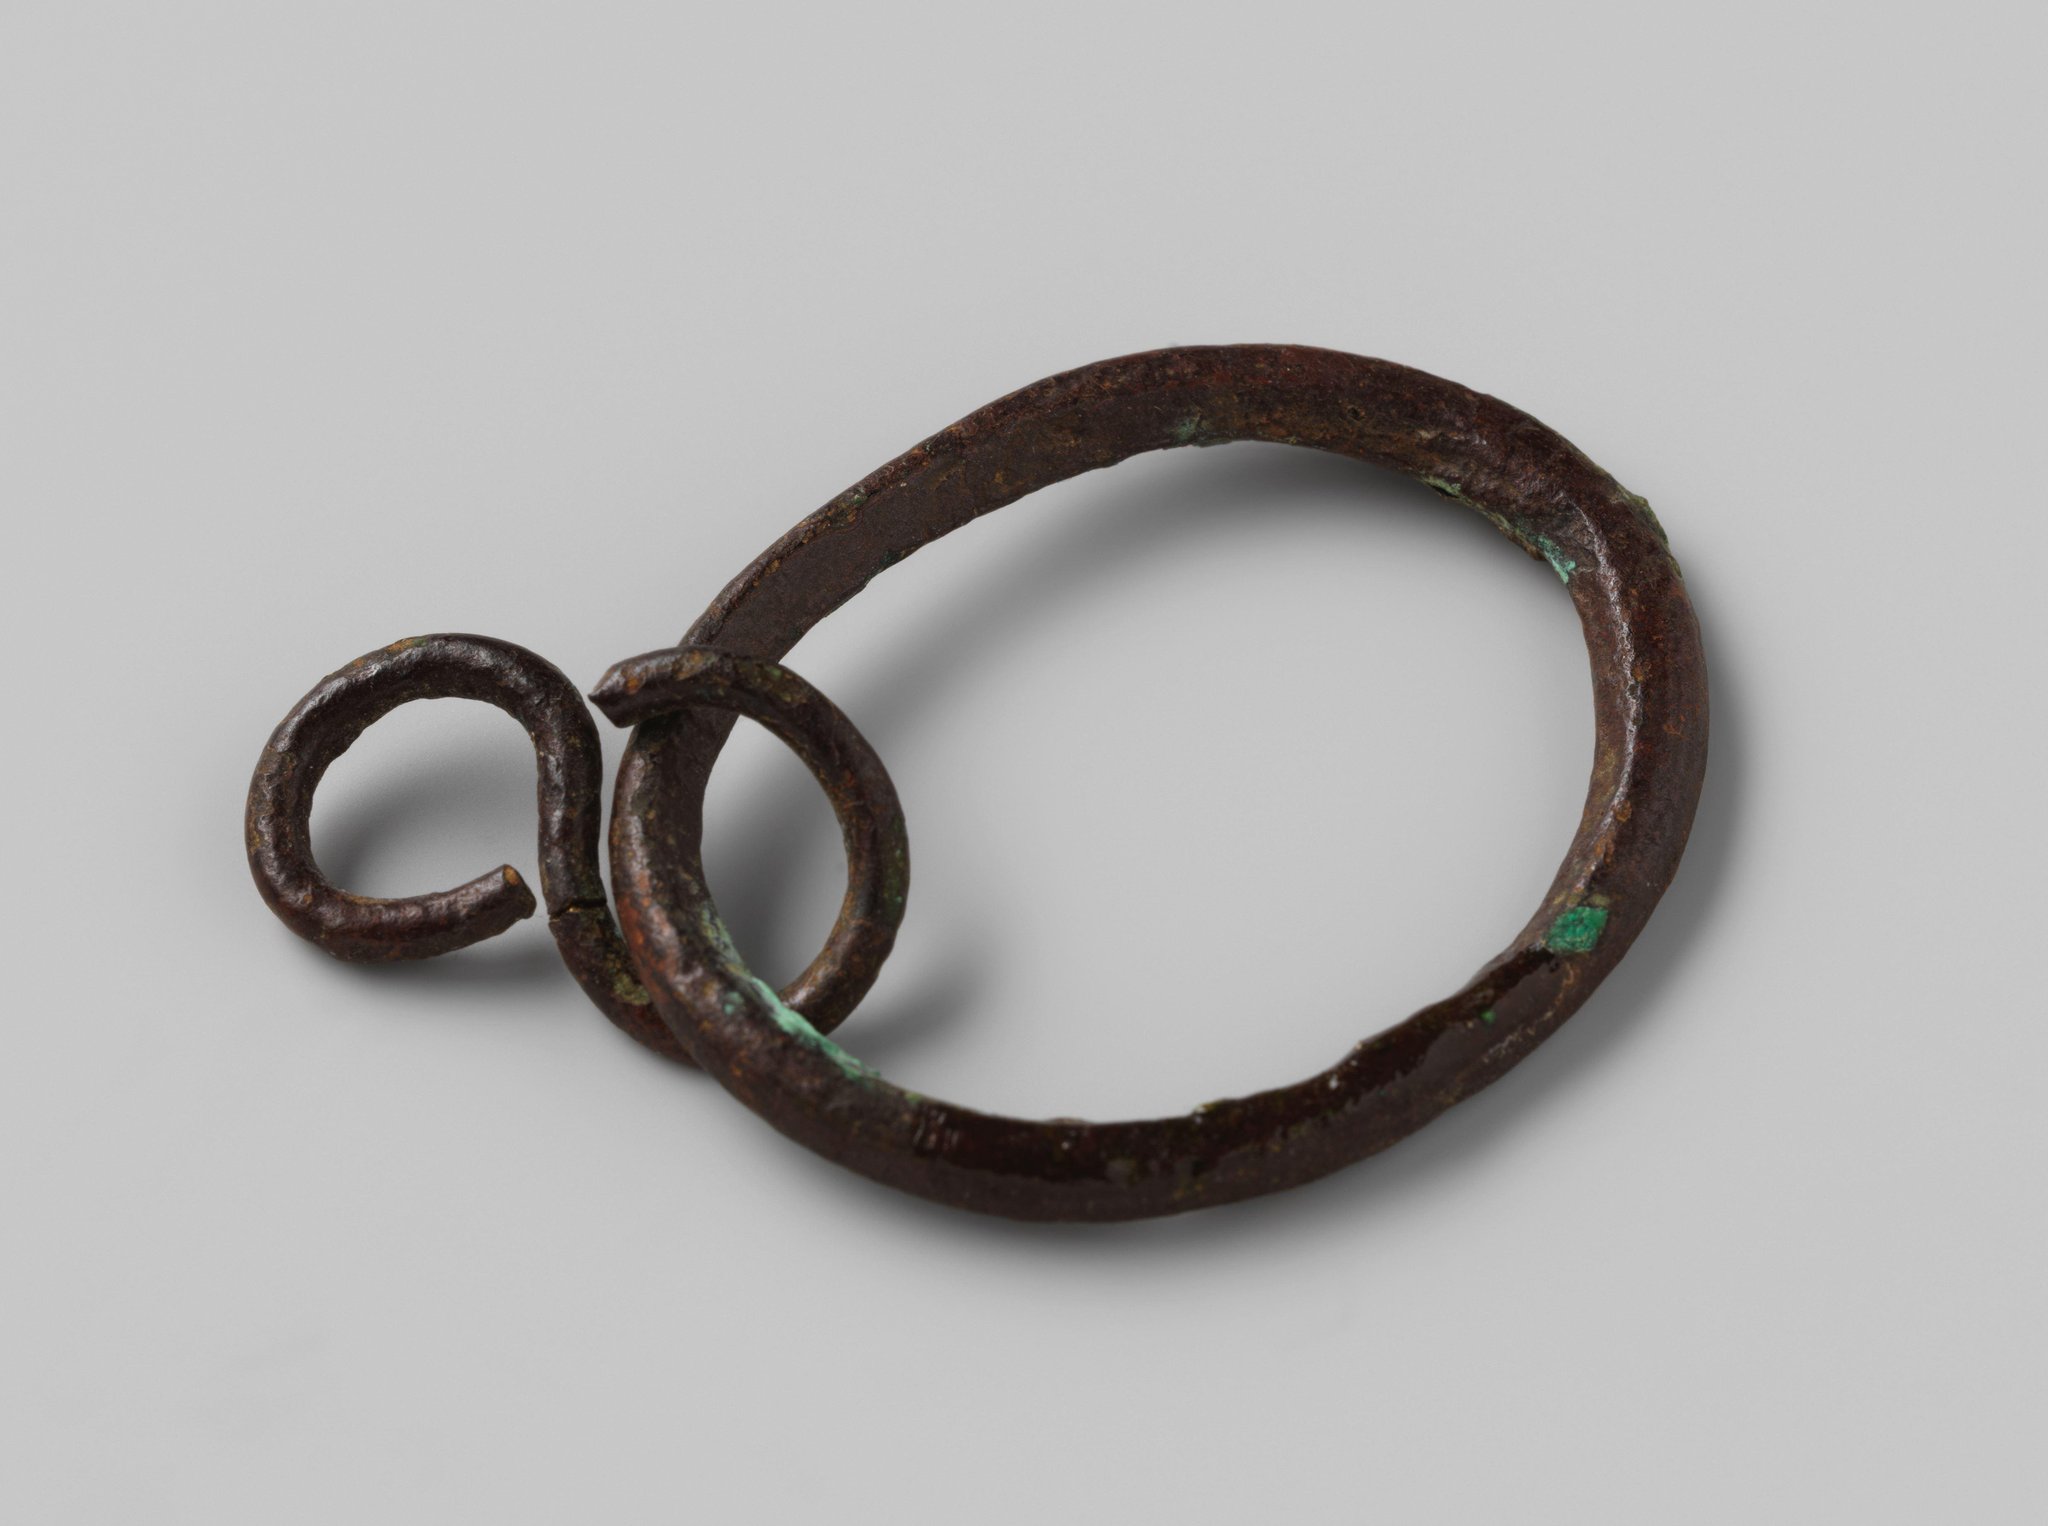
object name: ring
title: Ringvormig fragment met schakel uit het wrak van de Oost-Indiëvaarder Hollandia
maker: Anonymous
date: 1700-1743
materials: copper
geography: netherlands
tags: verenigde oostindische compagnie, hollandia (schip), annet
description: Varied parts or fragments, rings or ring-shaped fragments; id. 80H1, squashed, oval with link of chain.